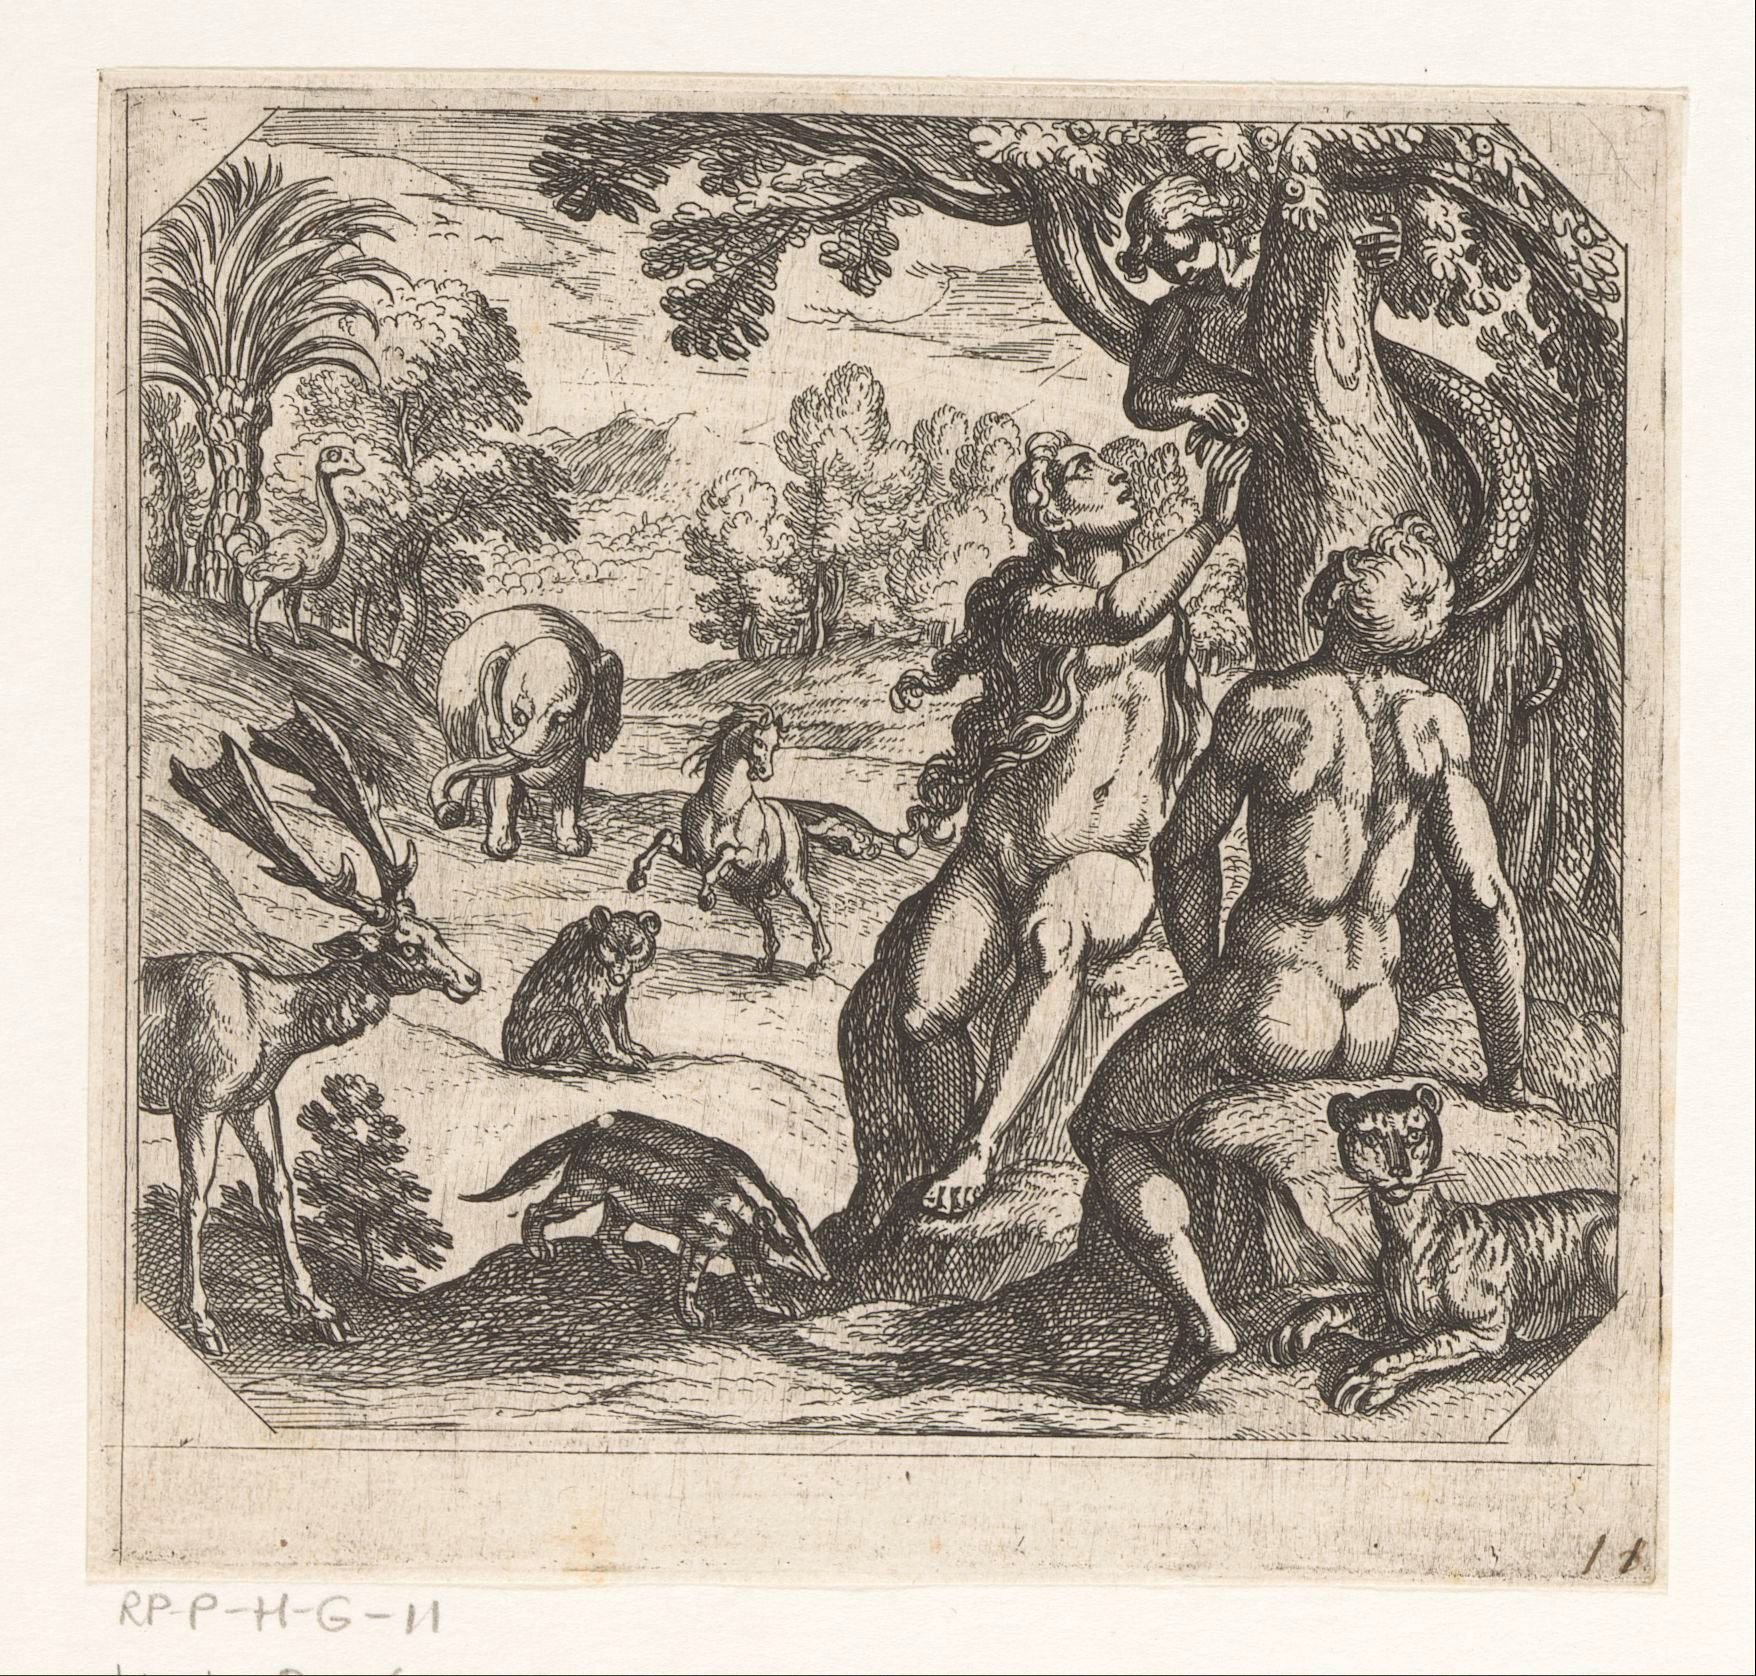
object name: print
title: De schepping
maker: antonio tempesta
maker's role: draughtsman, painter, print maker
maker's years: 1555-1630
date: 1565-1630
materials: paper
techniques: etching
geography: rome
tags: eve takes the fruit from the serpent (or the tree) in the presence of adam (who may be trying to stop her), temptation and fall (scenes with both adam and eve)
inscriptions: collector's mark: ‘Hinloopen’, number: ‘11’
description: Deze prent maakt deel uit van een serie van twaalf prenten van de schepping. De prenten zijn deels naar ontwerpen van Rafaël voor de Loggia van Rafaël in het Vaticaan, en deels naar prenten door Nicolaes de Bruyn naar ontwerpen van Maerten de Vos (zie: Holl. Dutch. vol. 45 nr. 1-10).